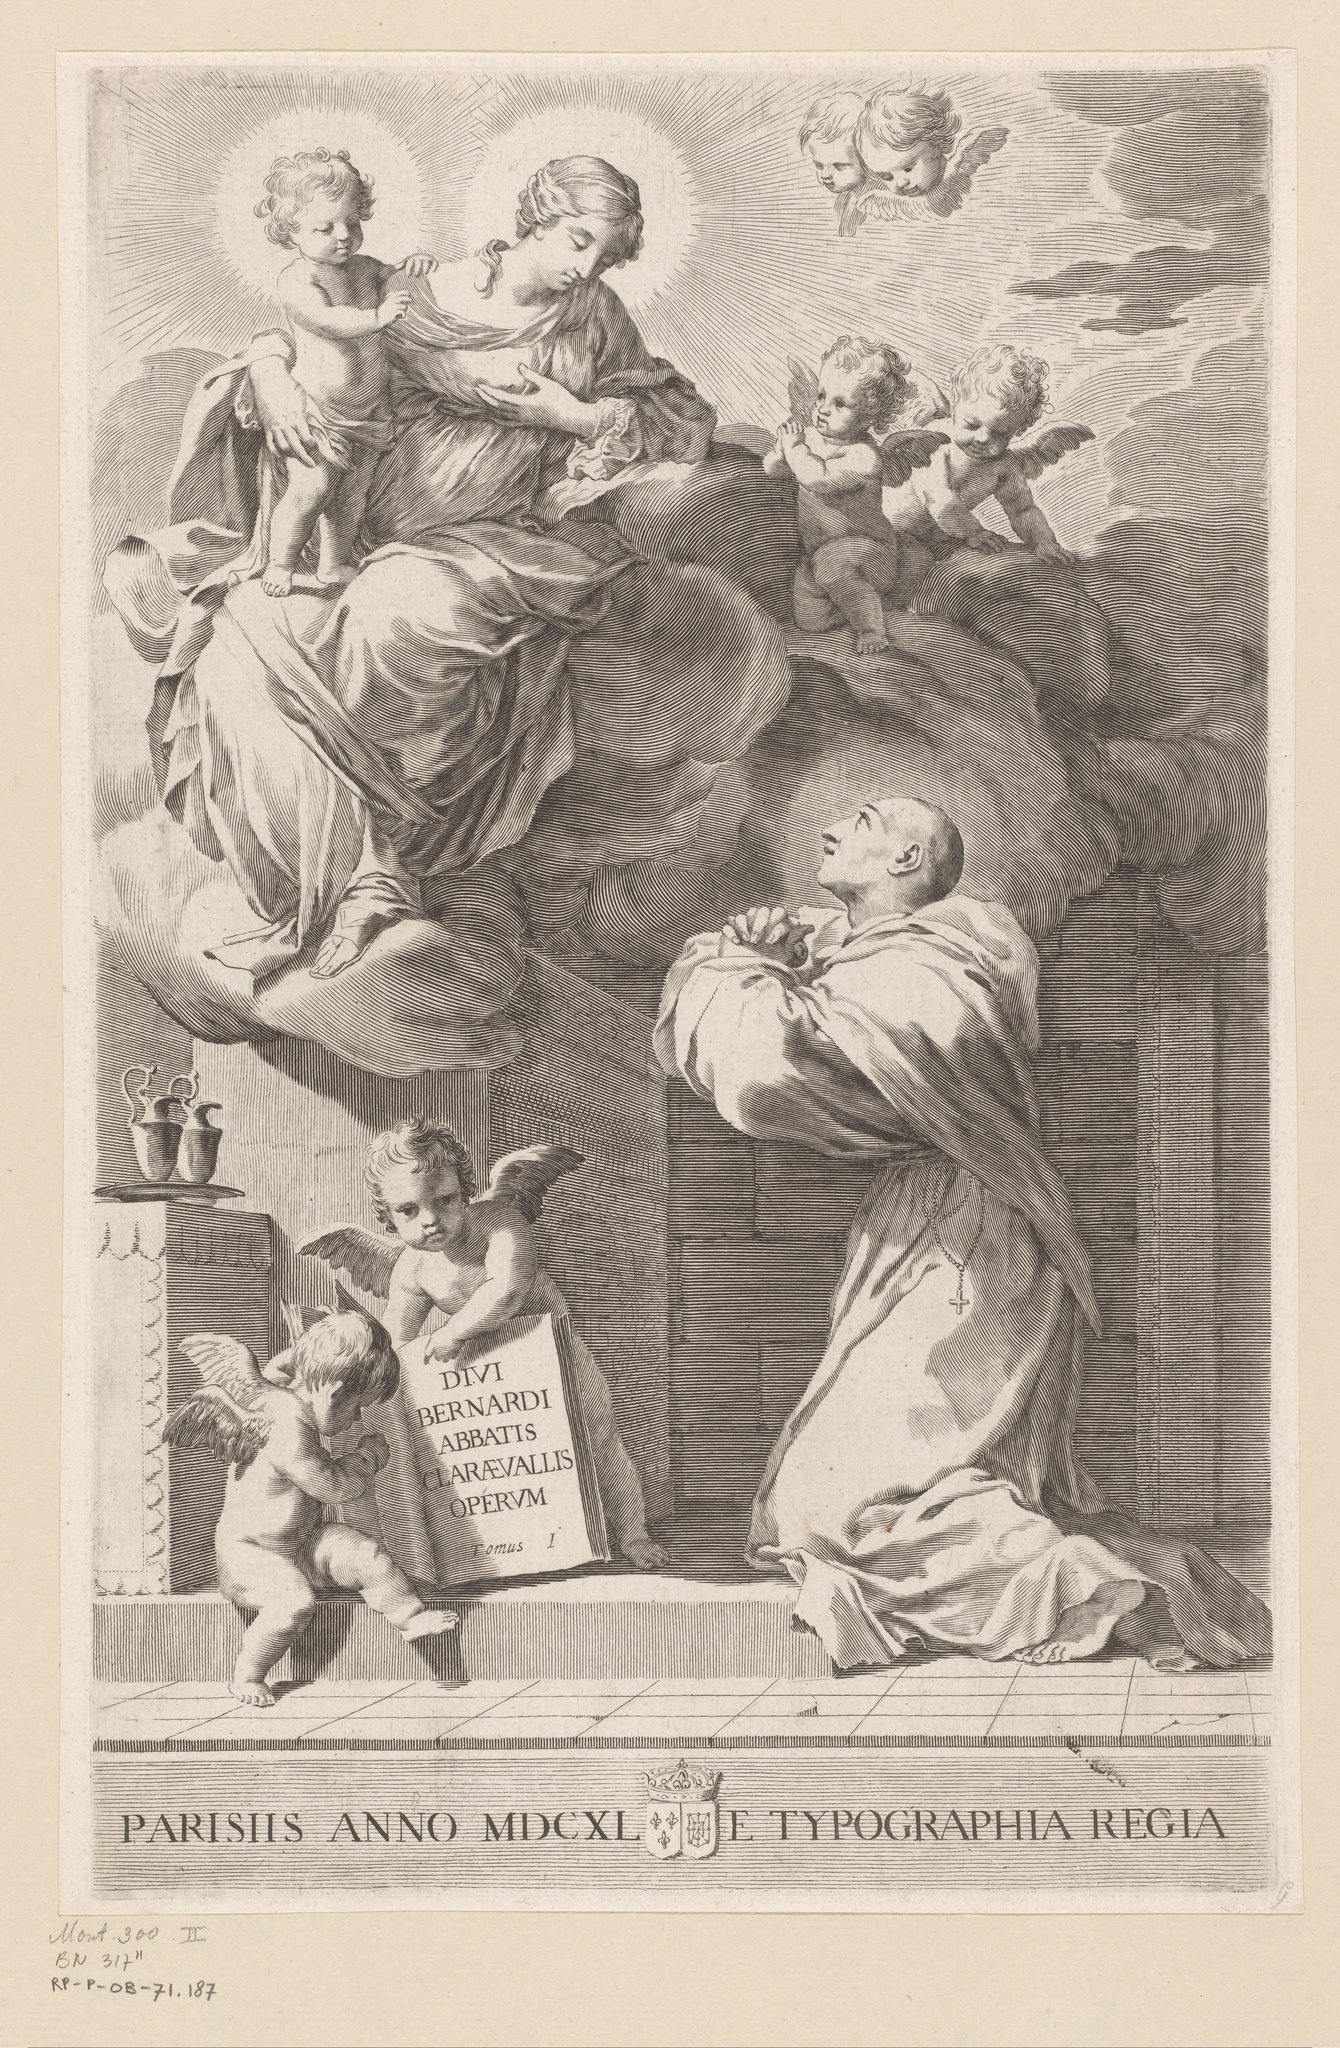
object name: titelblad, titelpagina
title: Titelpagina voor: Saint Bernardus, Divi Bernardi Abbatis (...), 1640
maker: claude mellan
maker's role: draughtsman, print maker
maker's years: 1598-1688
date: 1640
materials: paper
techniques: engraving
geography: paris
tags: the virgin mary, making a teaching gesture, appears to st. bernard of clairvaux writing at his desk ('doctrina')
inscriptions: collector's mark: Lugt 240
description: Titelpagina voor: Bernard, Saint. Divi Bernardi Abbatis Claraevallis Operum. Parijs: Imprimerie Royale, 1640, dl. 1. De tekening door Stella bevindt zich in de bibliotheek van l'Istituto Nazionale di Archeologia e Storia dell'Arte te Rome.